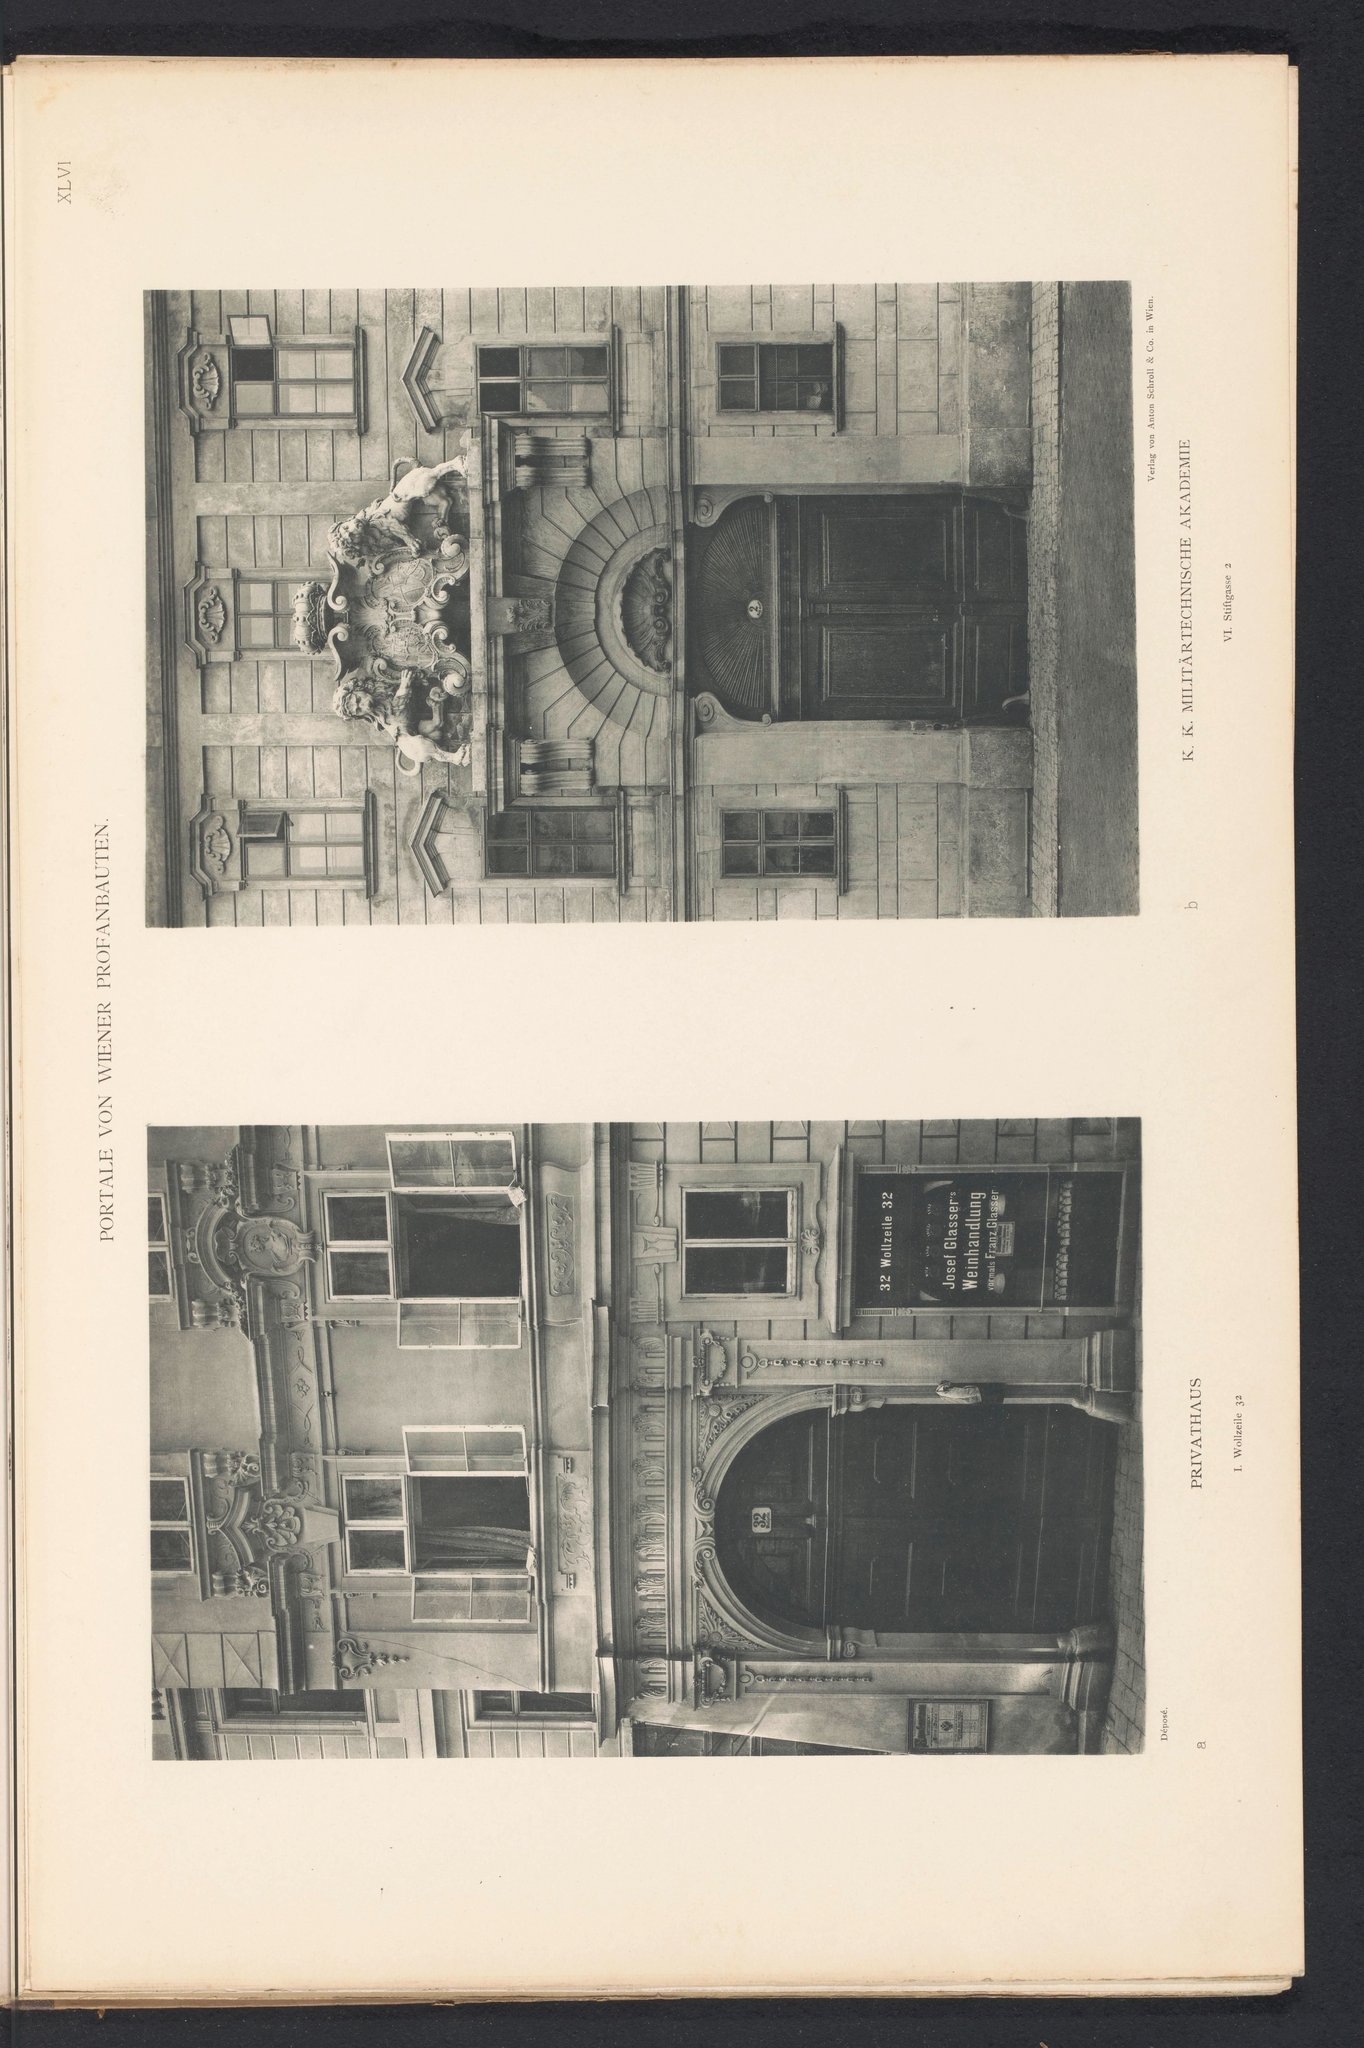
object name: photomechanical print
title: Twee toegangsportalen van panden te Wenen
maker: Anonymous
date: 1884-1894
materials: paper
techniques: photograph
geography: austria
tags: gate, entrance, façade (of house or building)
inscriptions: number: ‘XLVI’, inscription: ‘VI. Stiftgasse 2’, inscription: ‘I. Wollzeile 32’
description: Links een toegangsportaal van een woning aan Wollzeile 32, rechts het toegangsportaal van de Militärtechnische Akademie.